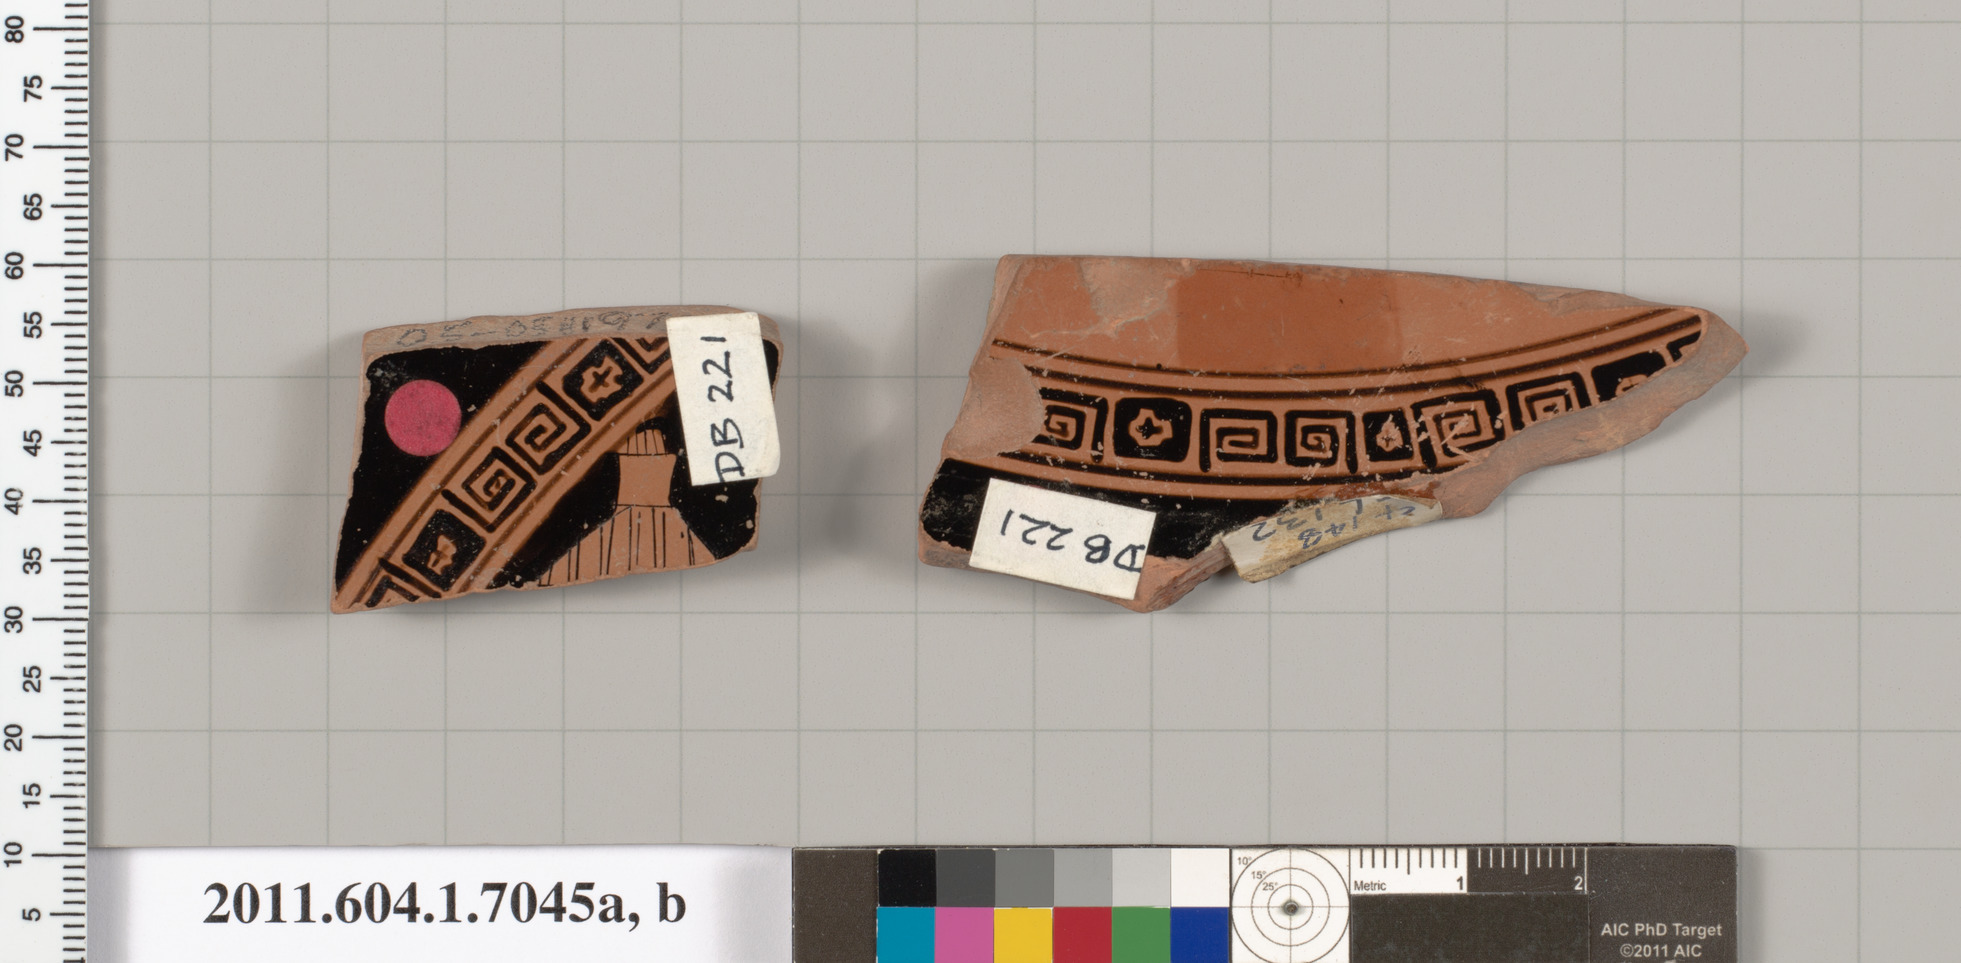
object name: kylix fragment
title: Terracotta fragments of a kylix (drinking cup)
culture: greek, attic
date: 500-480 BCE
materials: terracotta